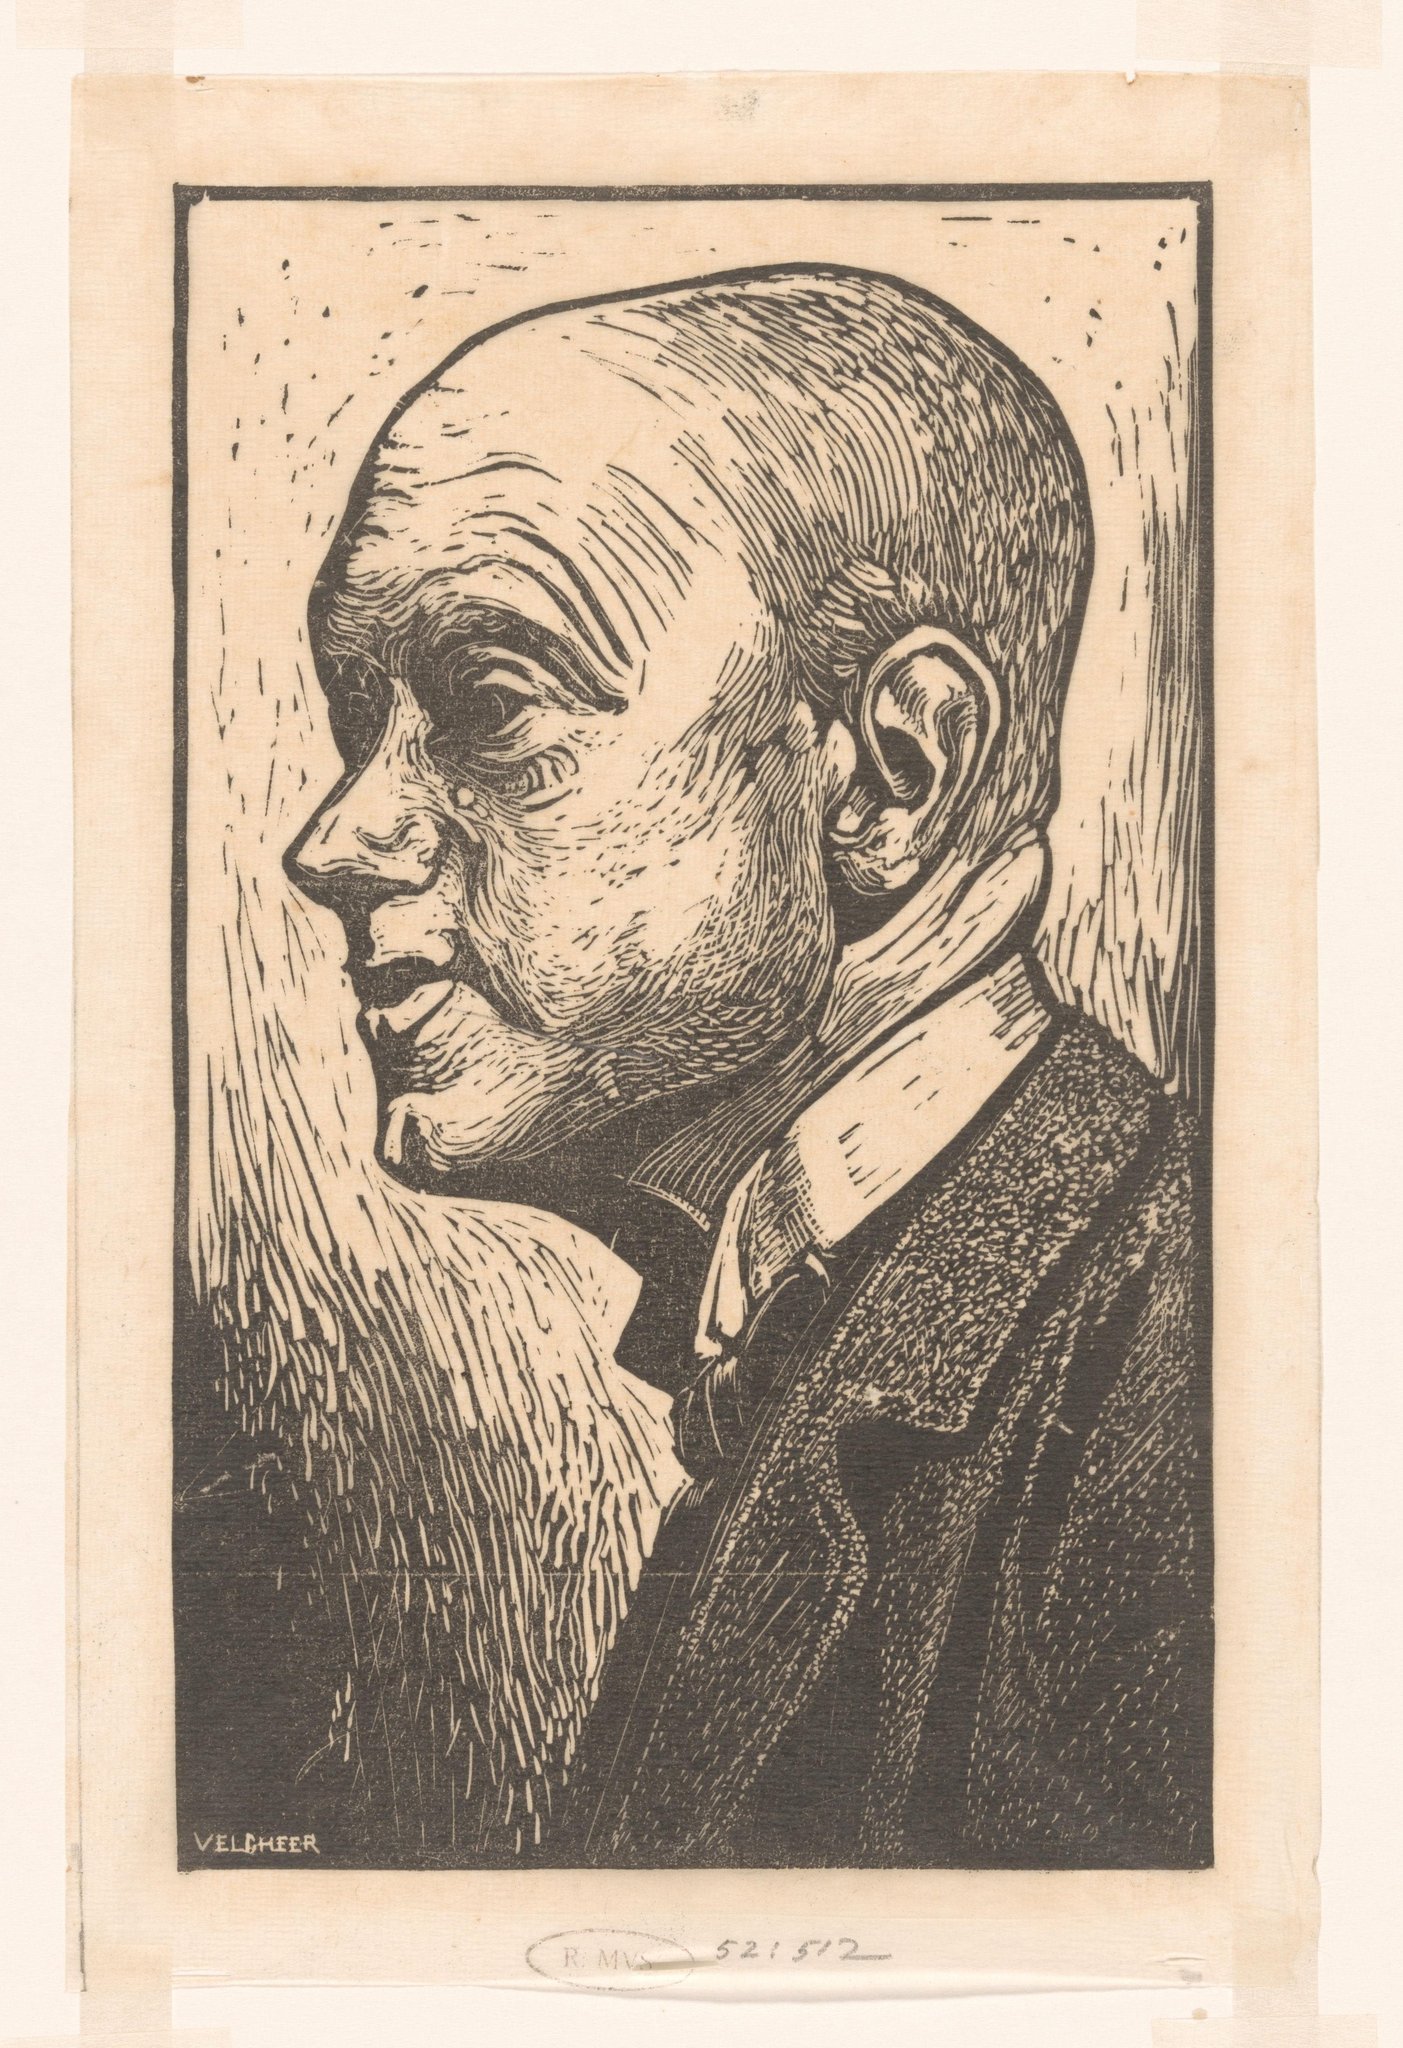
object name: print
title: Portret van Hendrik Johannes Haverman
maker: jacobus gerardus veldheer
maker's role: draughtsman, print maker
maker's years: 1866-1954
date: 1876-1952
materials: paper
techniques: woodcut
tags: amsterdam, the hague, draughtsman, hendrik johannes haverman, historical persons, portrait, self-portrait of artist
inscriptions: collector's mark: Lugt 2228